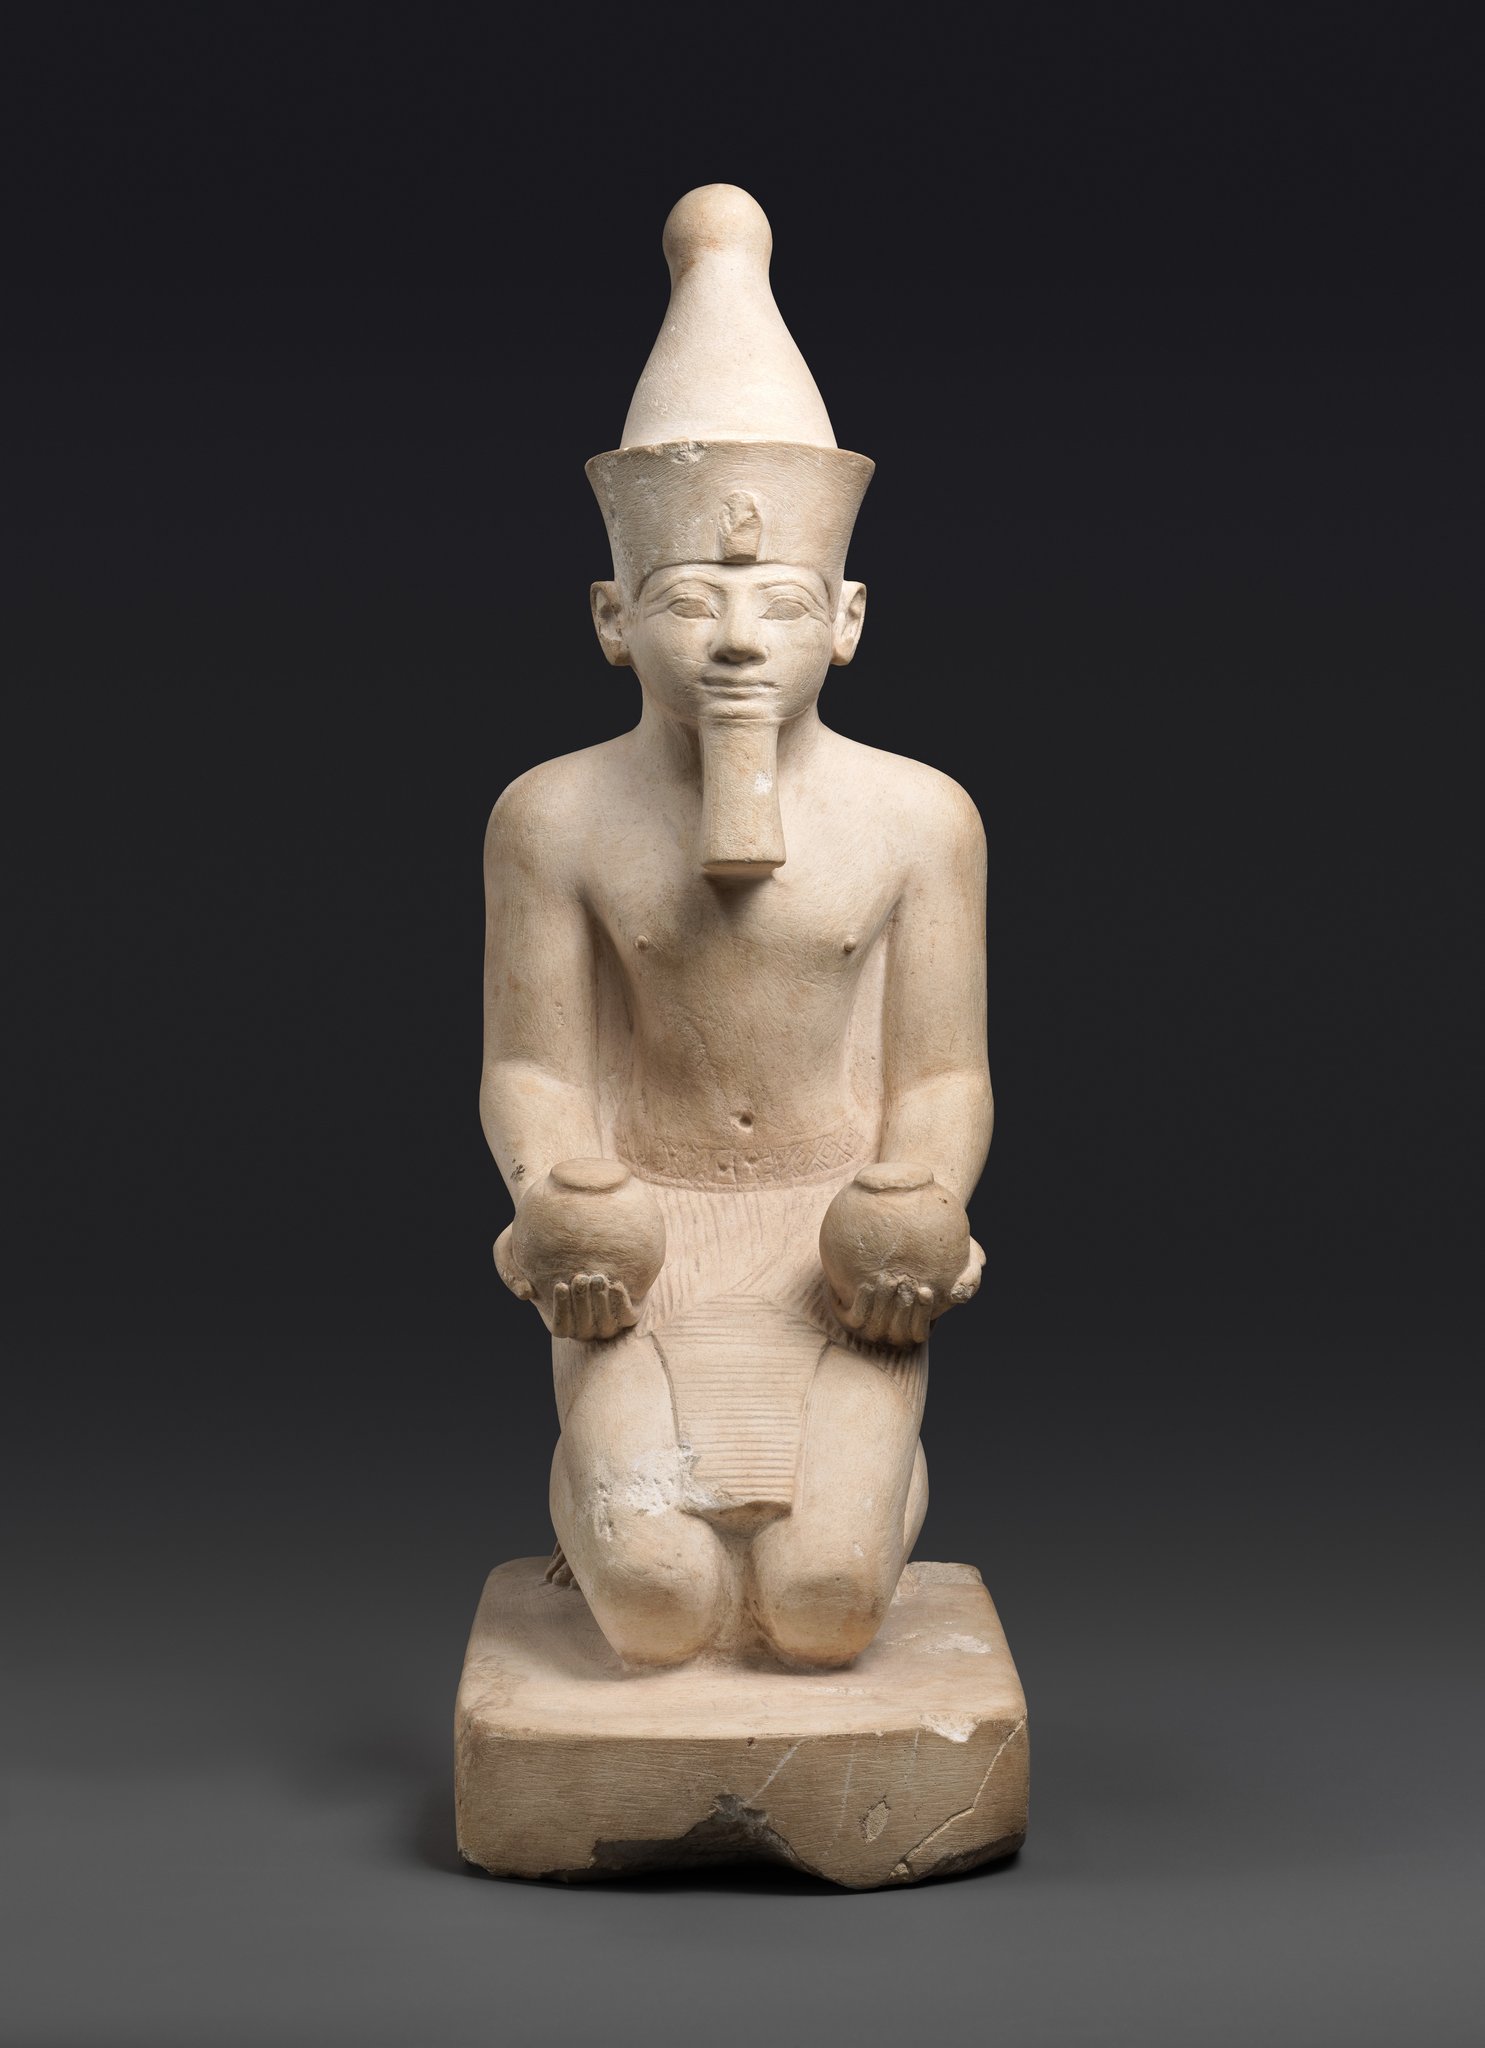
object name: statue, amenhotep ii, double crown, nu jar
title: Amenhotep II in the Double Crown, Kneeling and Offering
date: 1427-1400 BCE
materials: limestone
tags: men